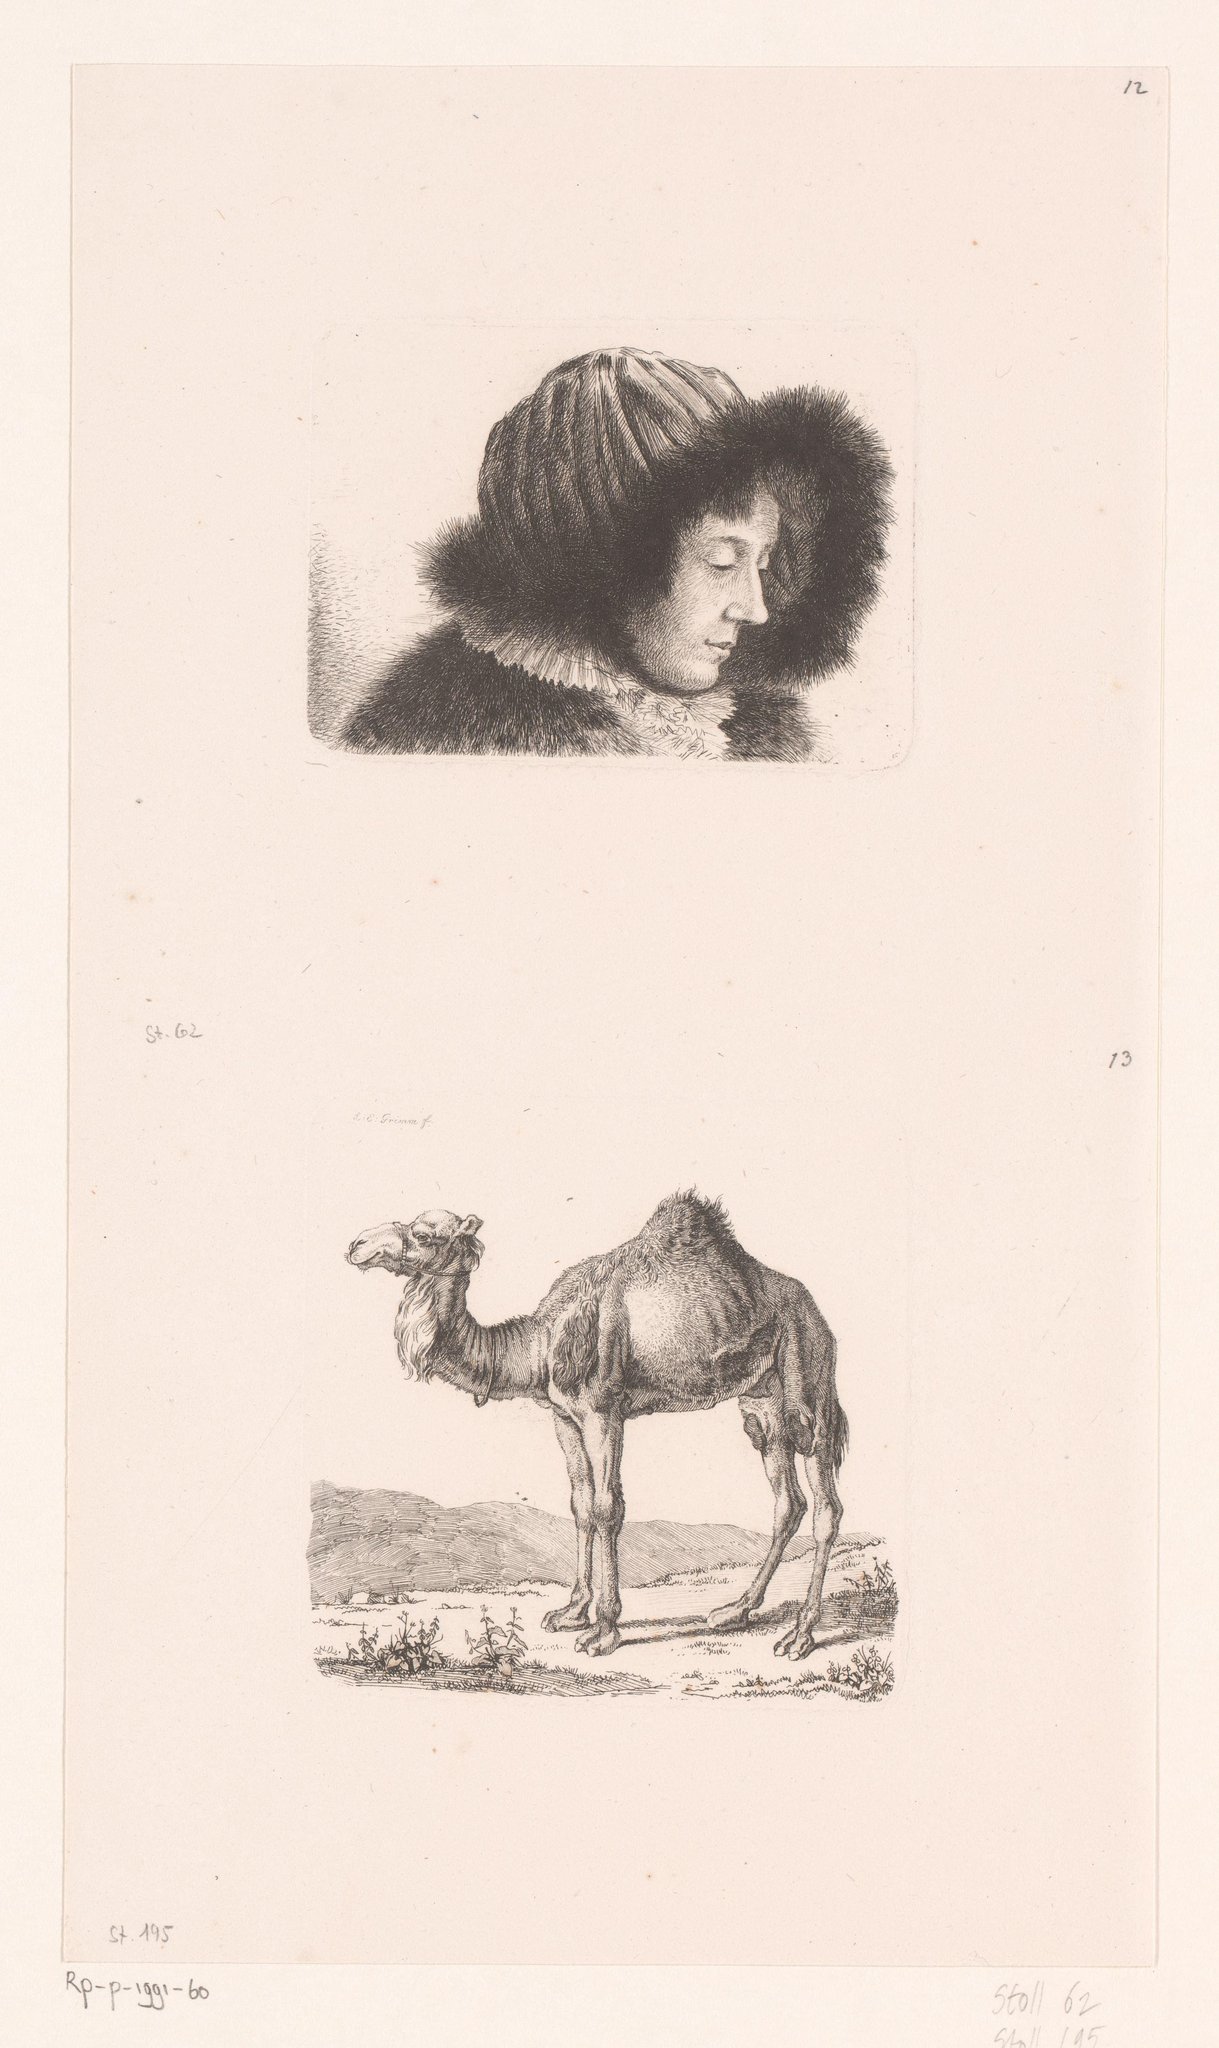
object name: print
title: Portret van Gunda von Savigny met pelsmuts en een staande kameel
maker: ludwig emil grimm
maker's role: print maker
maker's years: 1790-1863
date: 1809-1863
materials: paper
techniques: etching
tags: hoofed animals: dromedary, historical persons - bb - woman, head-gear (with name)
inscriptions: collector's mark: Lugt 2228, collector's mark: Lugt 2760